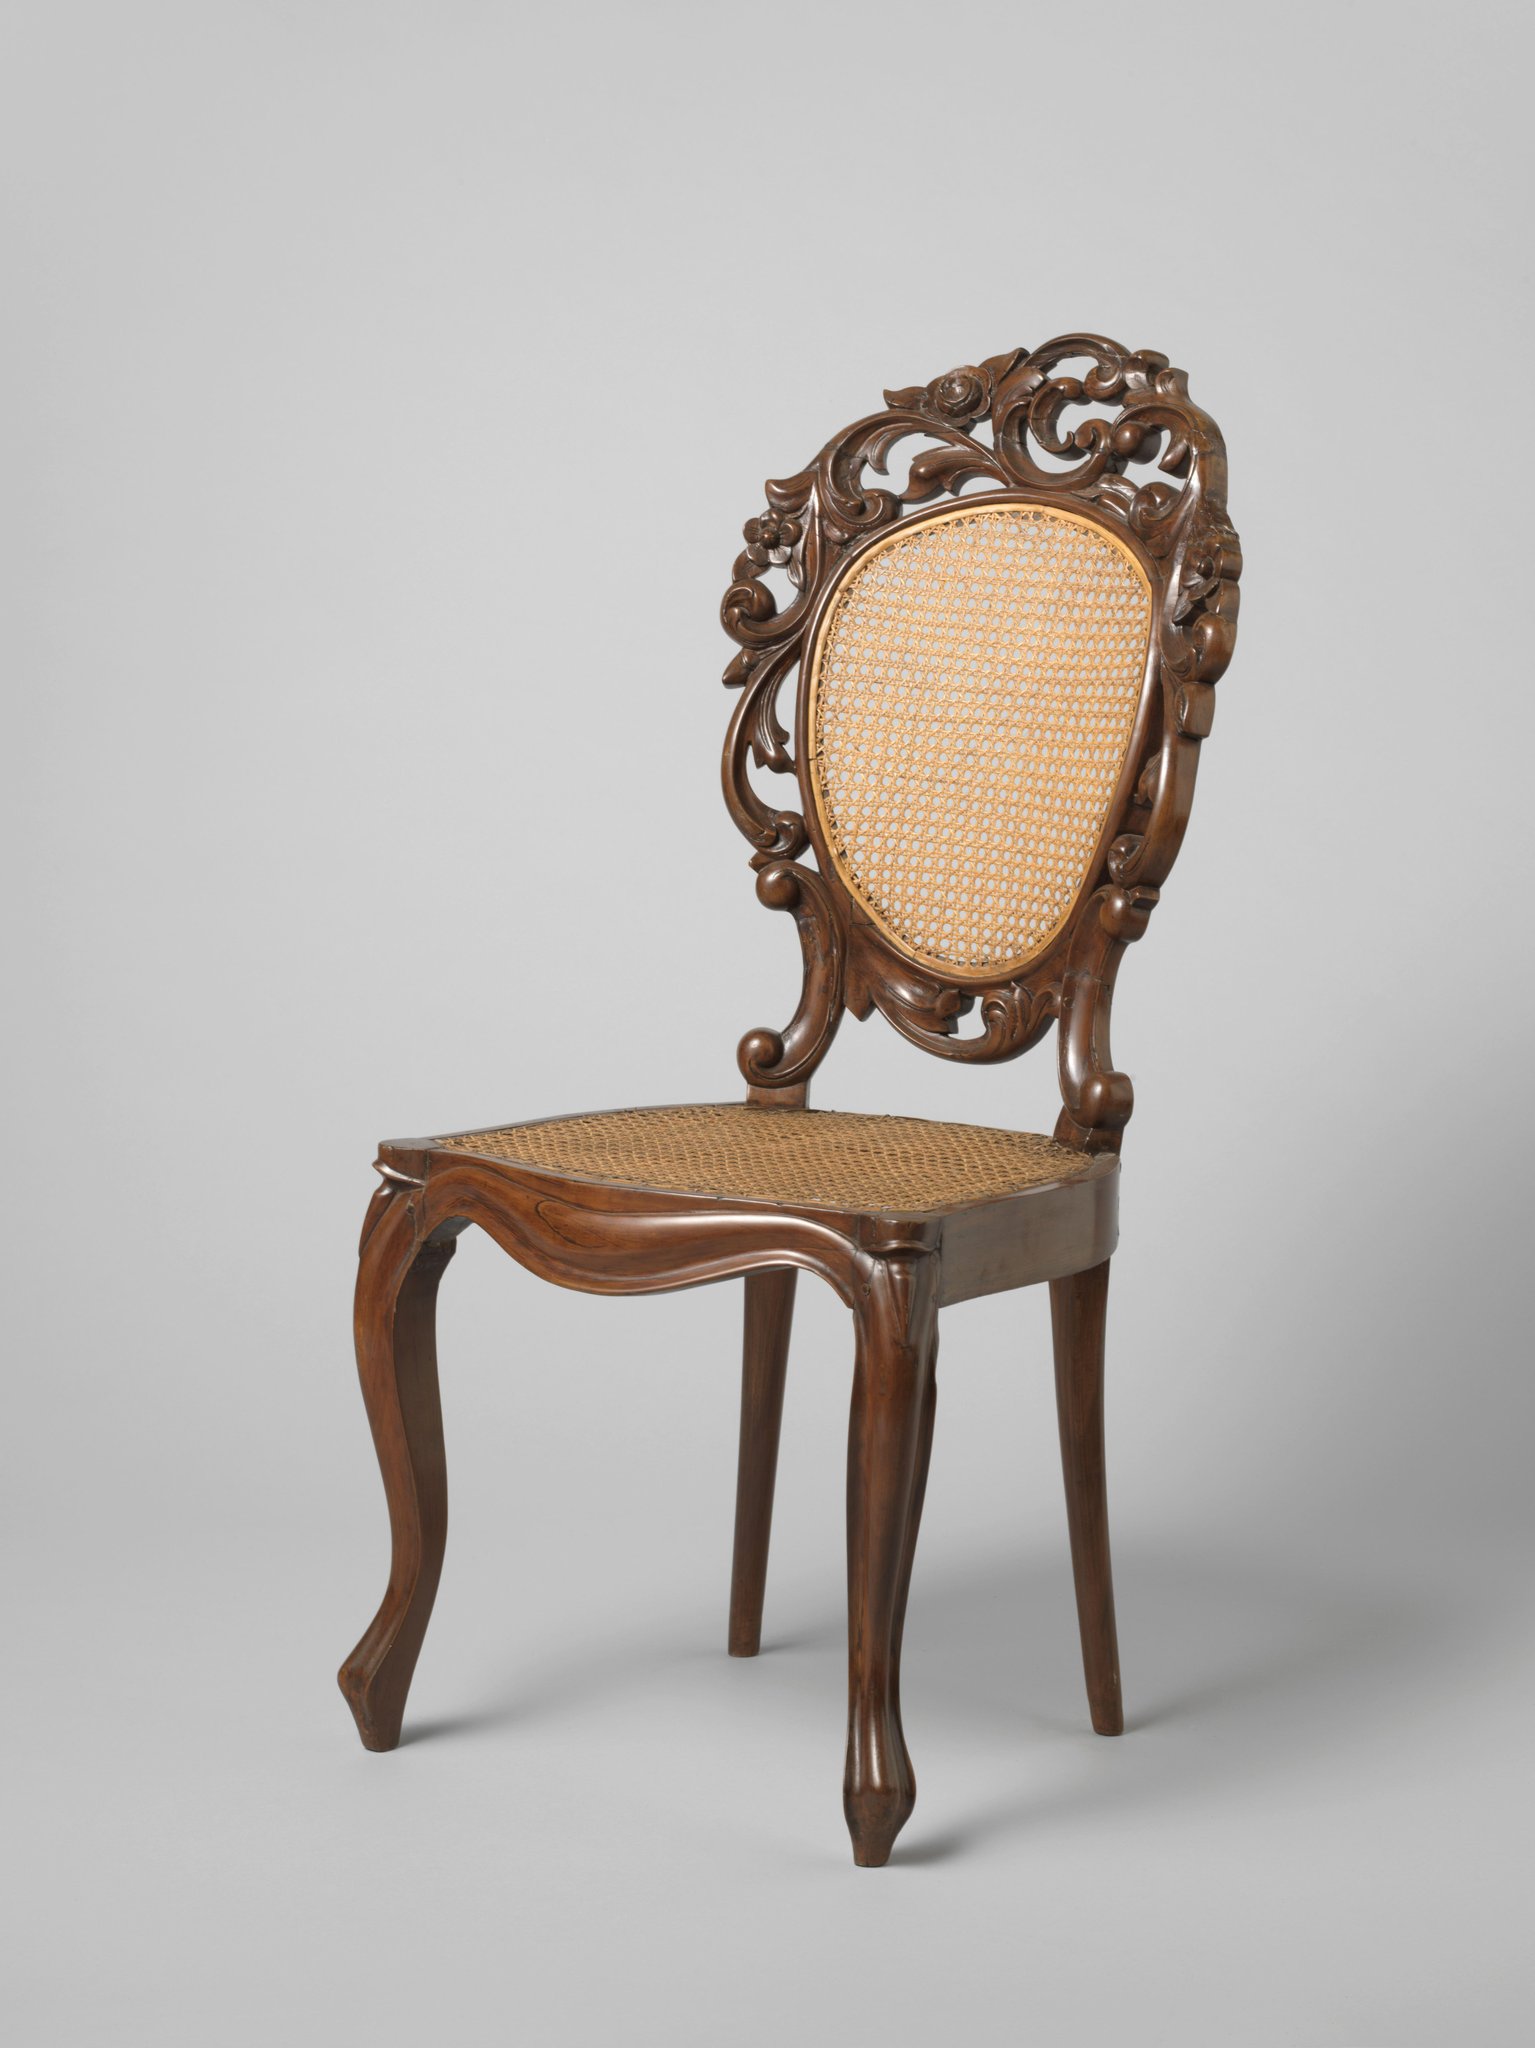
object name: chair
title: Stoel in neo-rococo-stijl van djatihout, zitting en rug bespannen met riet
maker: Anonymous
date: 1850-1875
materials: wood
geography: indonesia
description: Stoel in neo-rococo-stijl van djatihout en met riet bespannen zitting en rug. S-vormig gebogen voorpoten en en gebogen voorregel en eivormige rug, rustend op C-voluutvormige stutten en geheel omgeven door asymmetrisch opengewerkt snijwerk van C- en S-voluten met bloem- en bladmotieven.